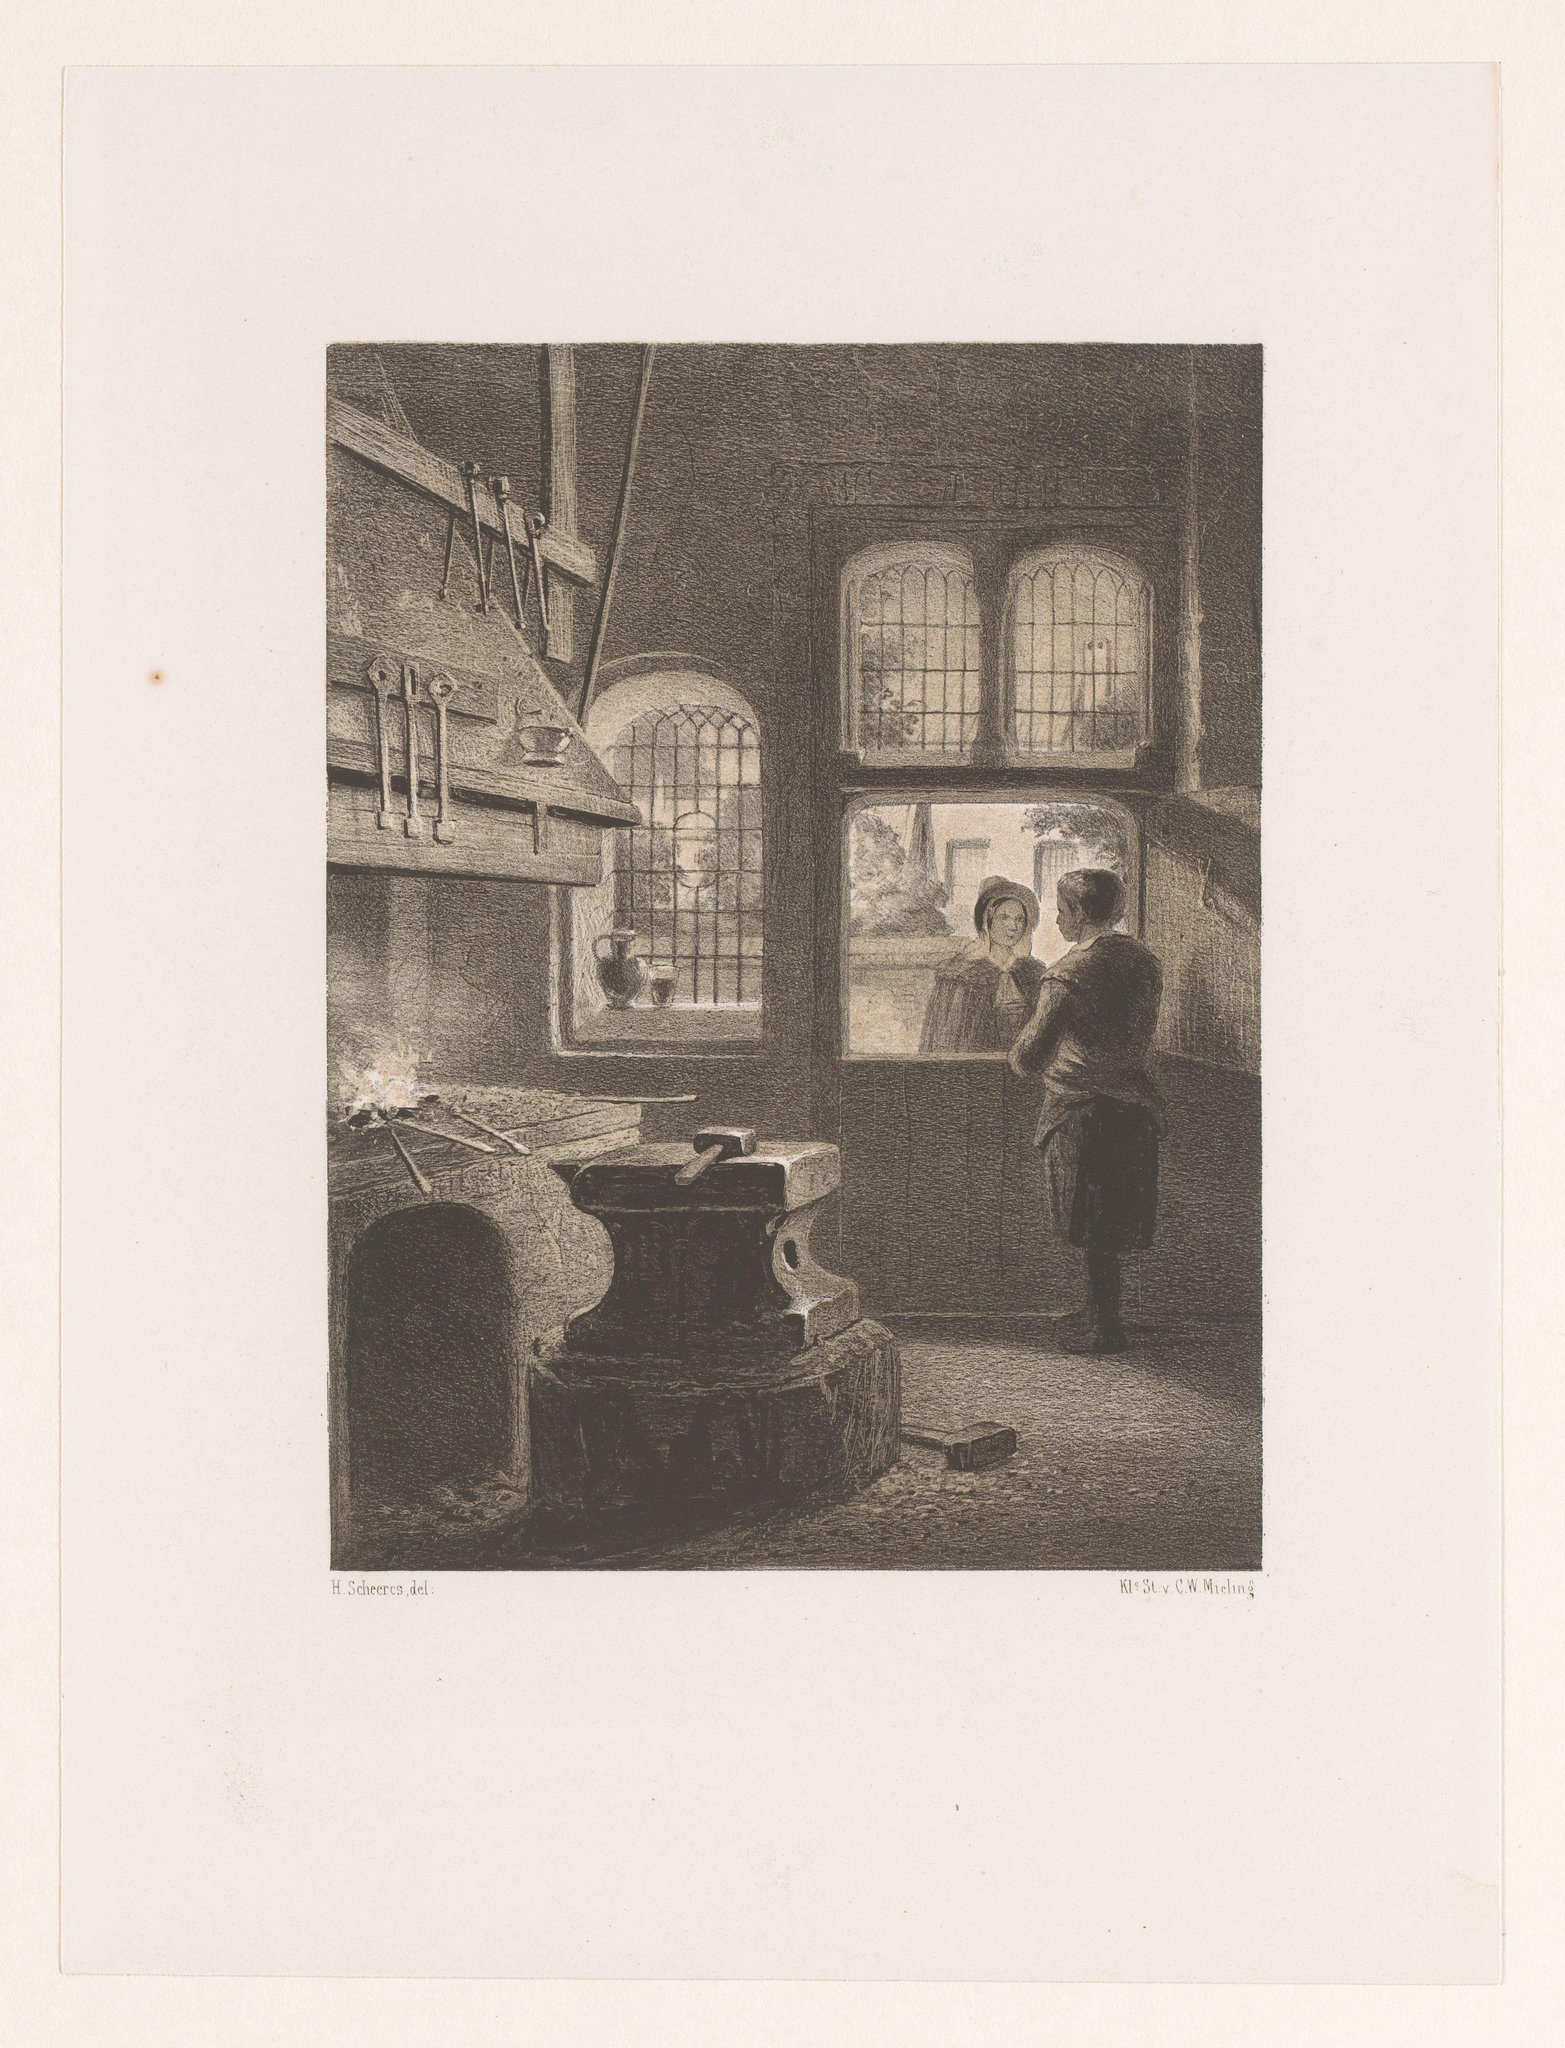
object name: print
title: Smid in gesprek met vrouw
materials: paper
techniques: tone lithography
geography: the hague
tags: smith, blacksmith, conversation, dialogue; conversation piece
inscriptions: collector's mark: Lugt 2760, collector's mark: Lugt 2166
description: Een smid staat bij de deur van zijn werkplaats en is via het geopende bovendeel in gesprek met een vrouw buiten.